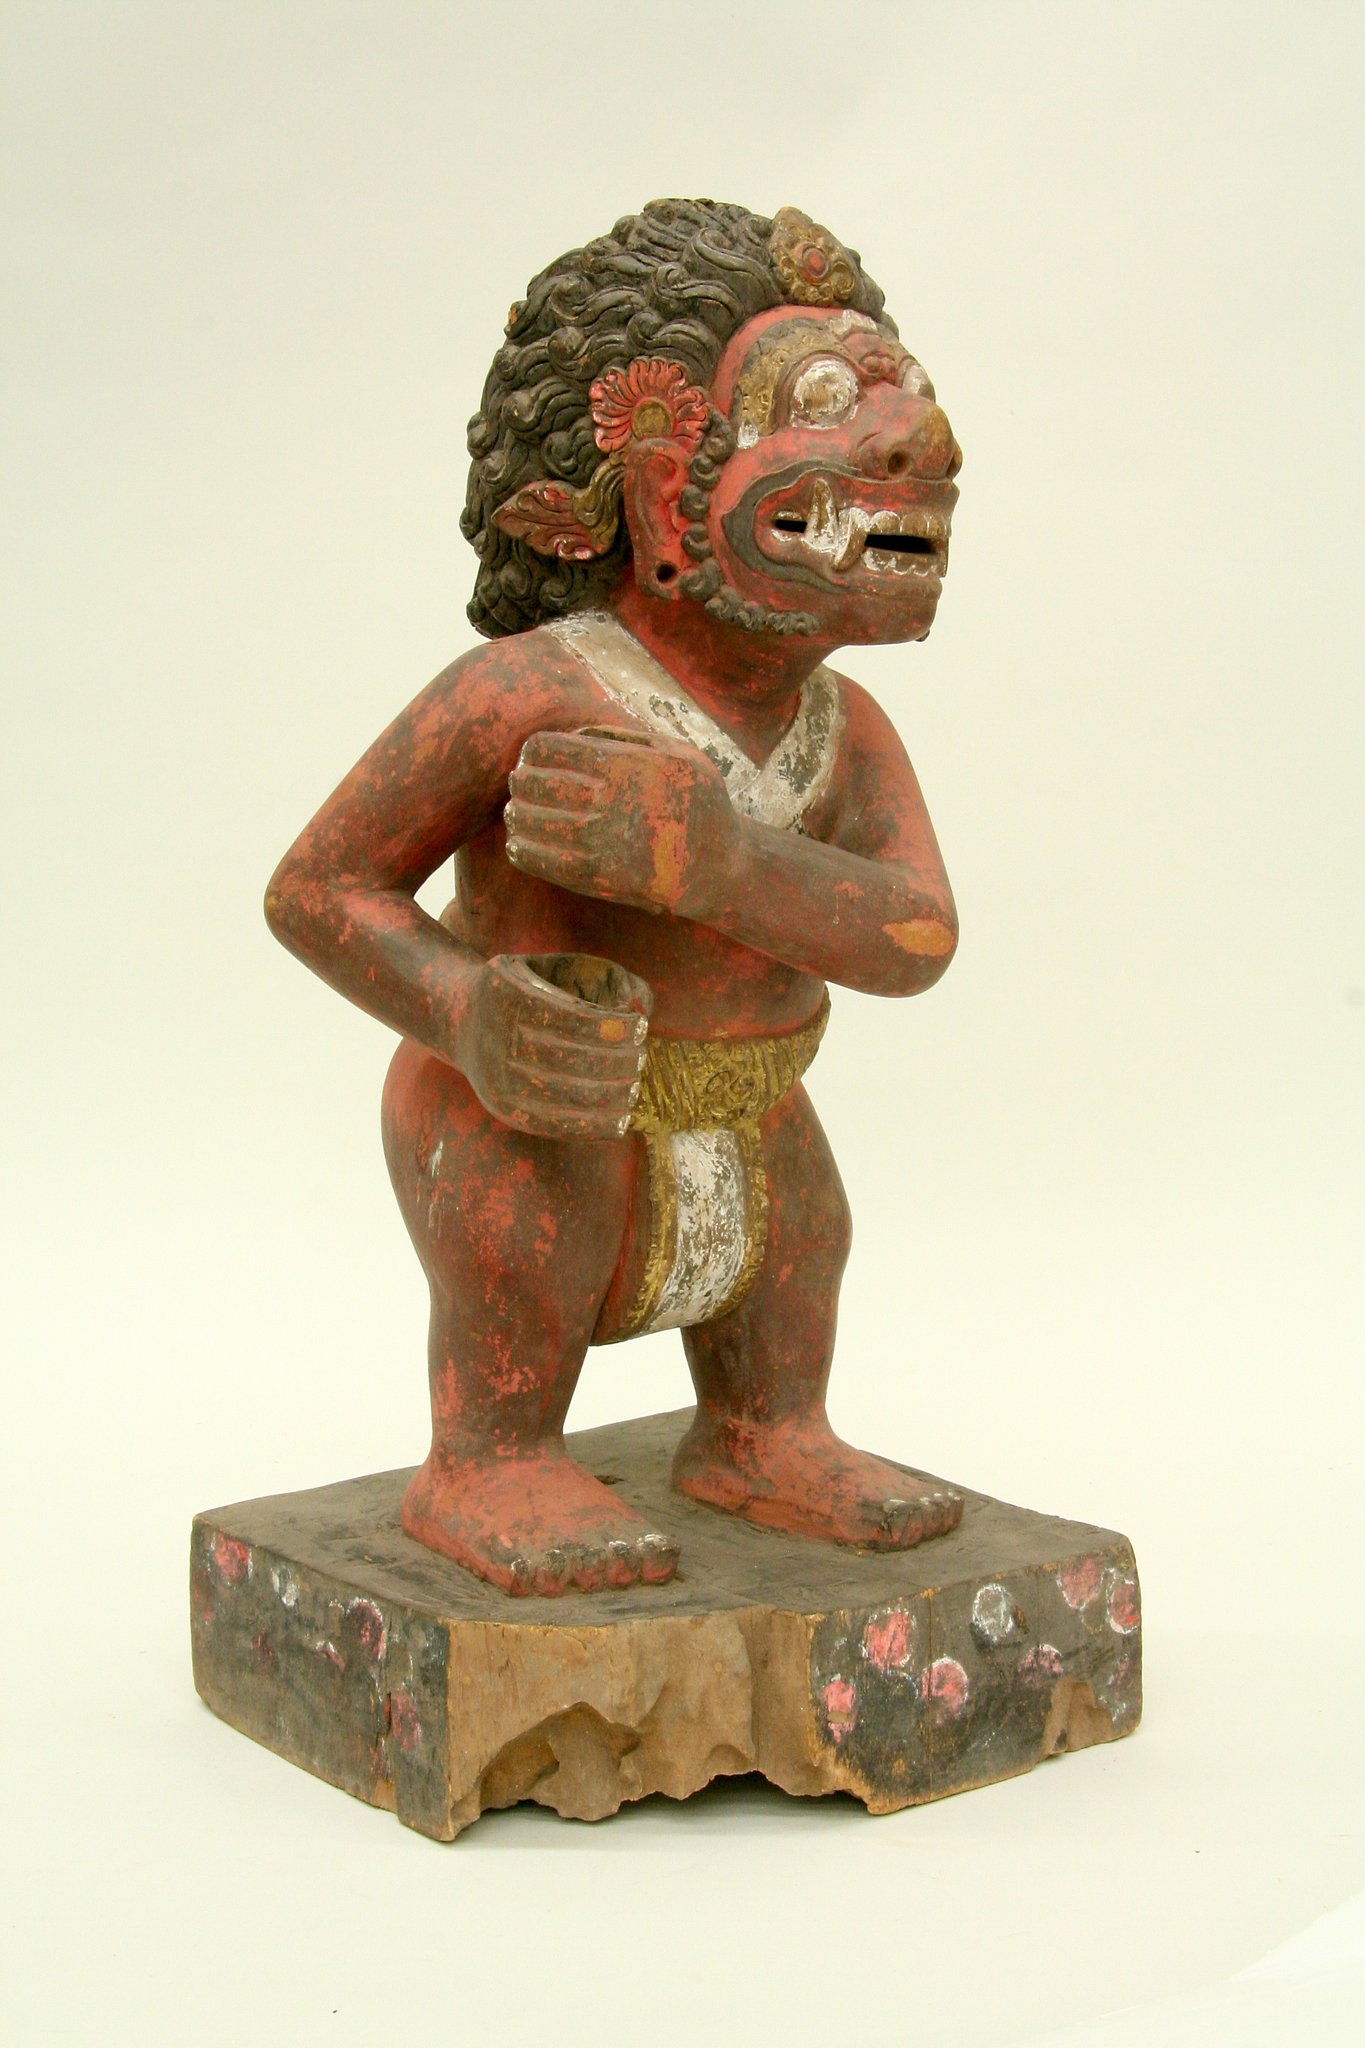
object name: kris stand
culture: balinese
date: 1501-1900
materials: wood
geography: indonesia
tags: men